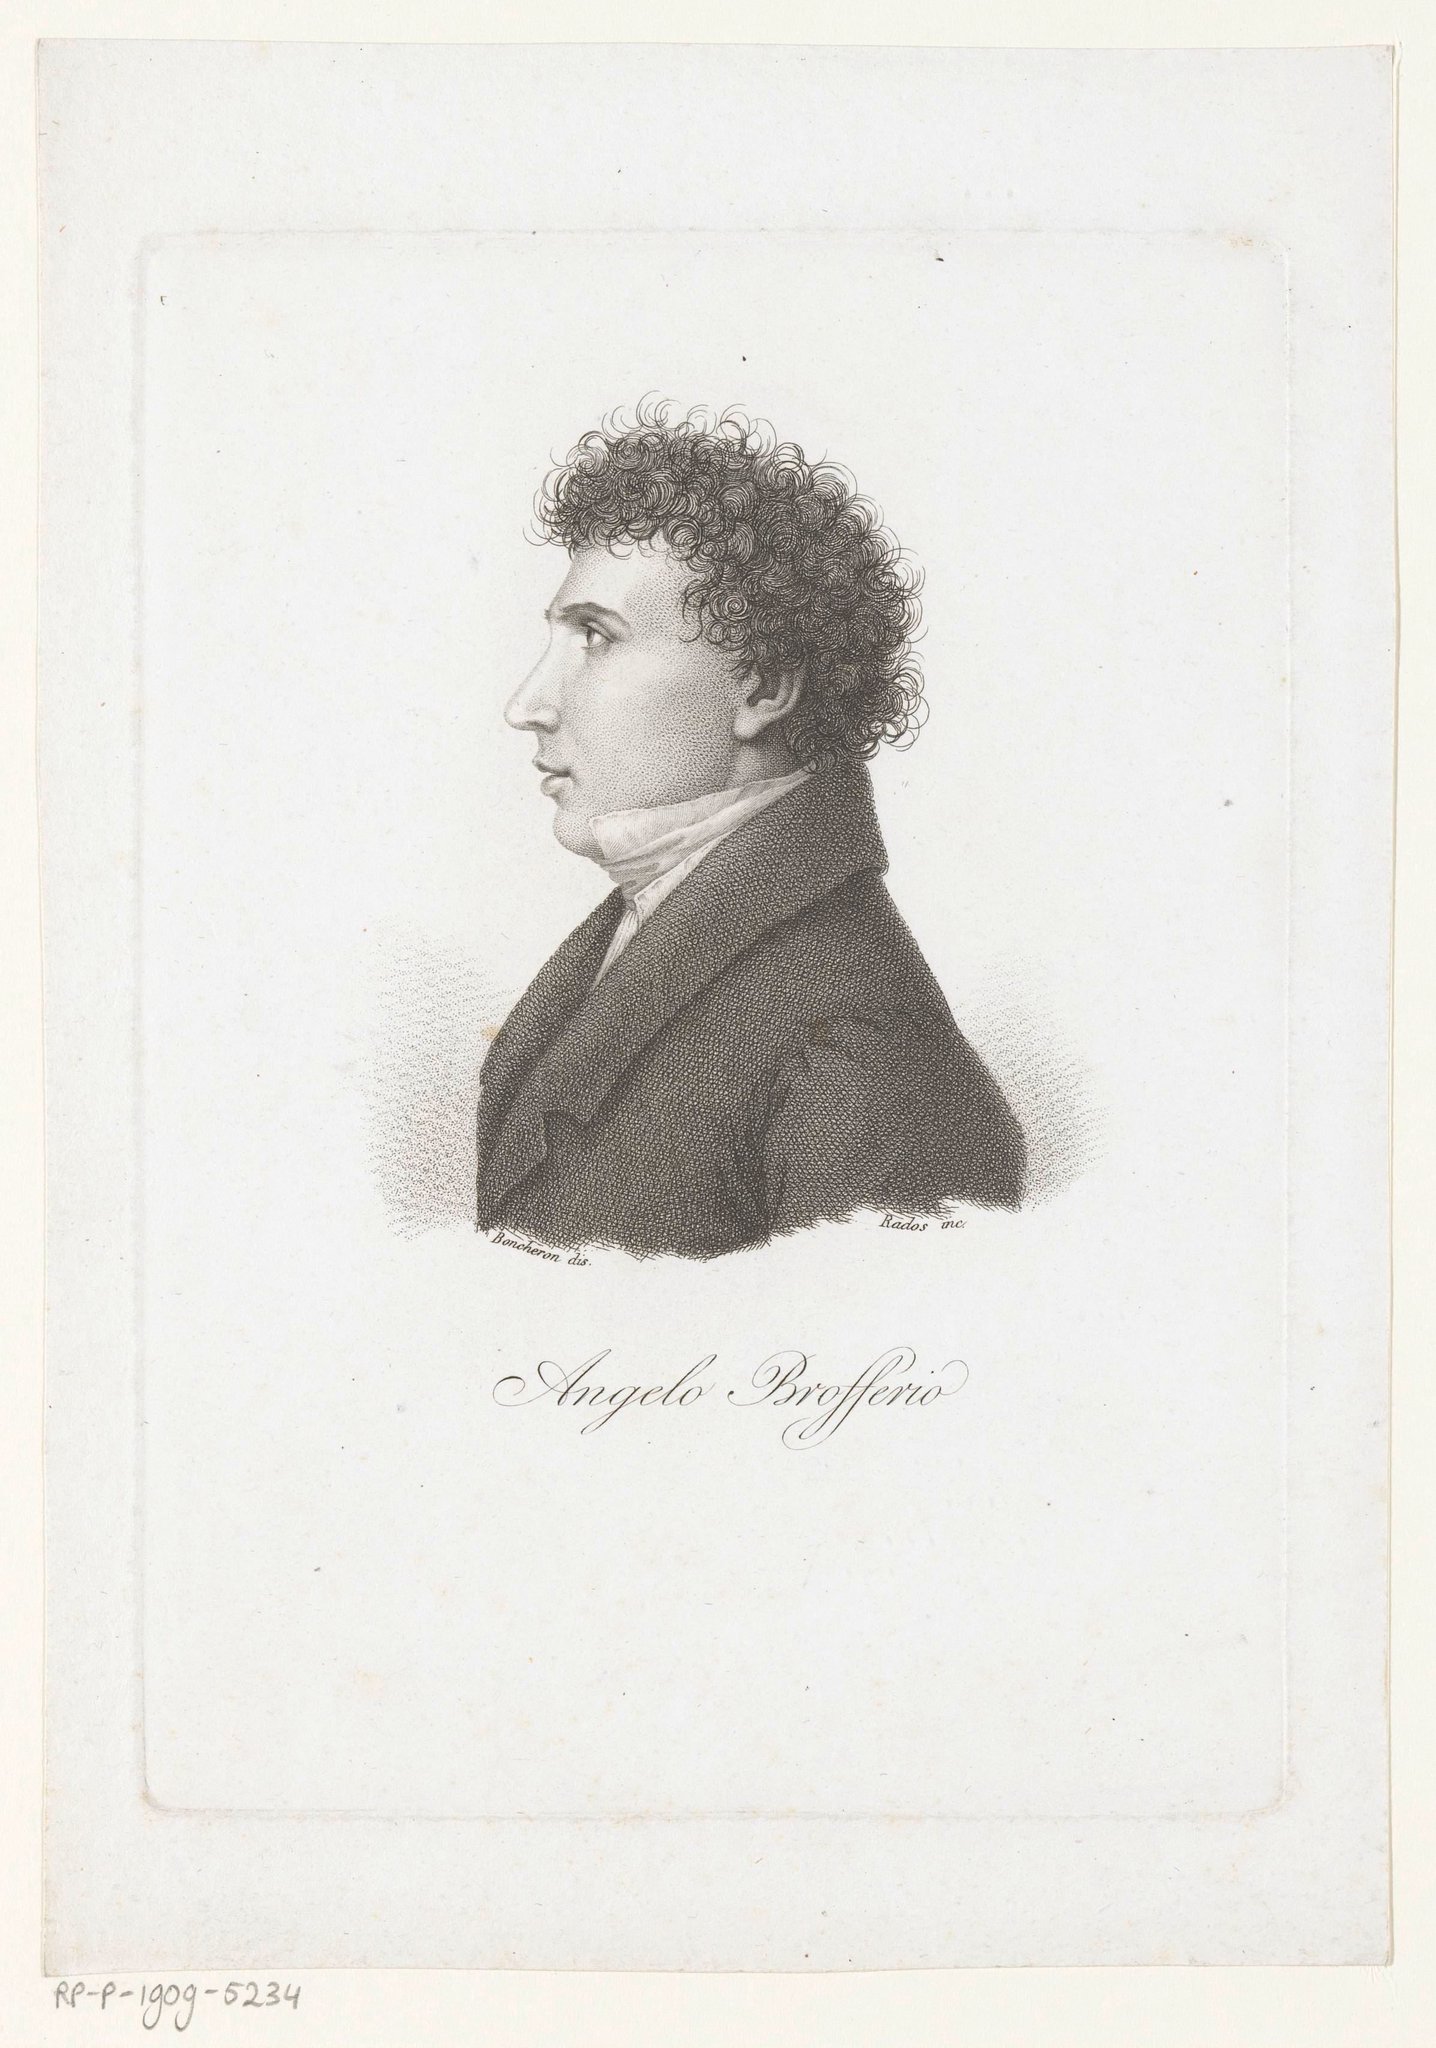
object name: print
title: Portret van Angelo Brofferio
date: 1783-1840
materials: paper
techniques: etching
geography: italy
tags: politician, historical persons, portrait of a writer, politician, e.g. party leader, writer, poet, author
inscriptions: collector's mark: Lugt 2228